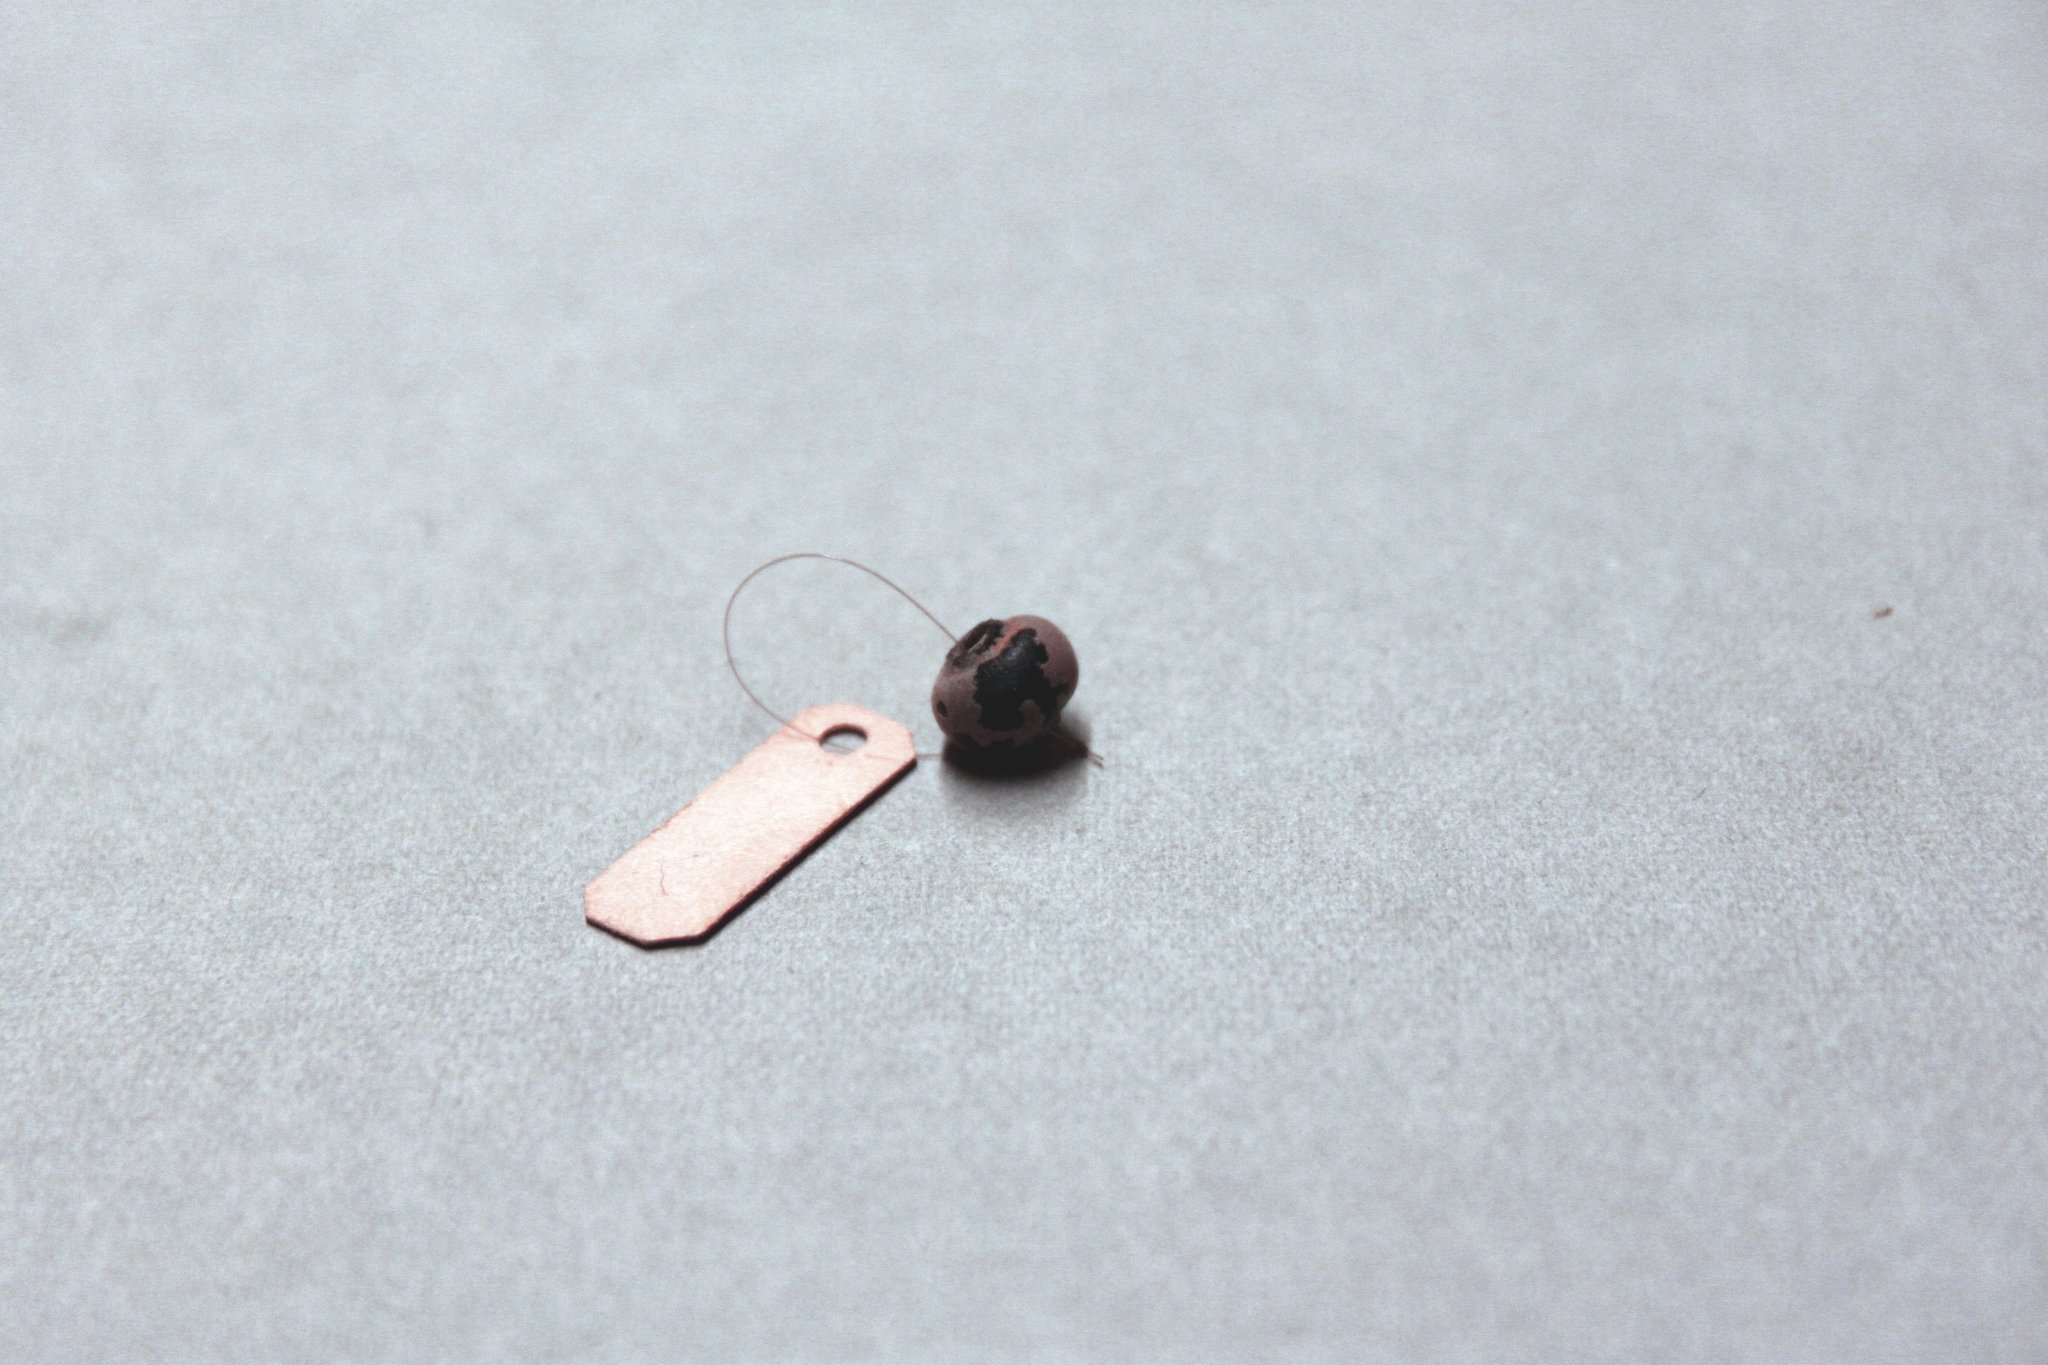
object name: bead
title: Beads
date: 701-1300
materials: glass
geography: iran